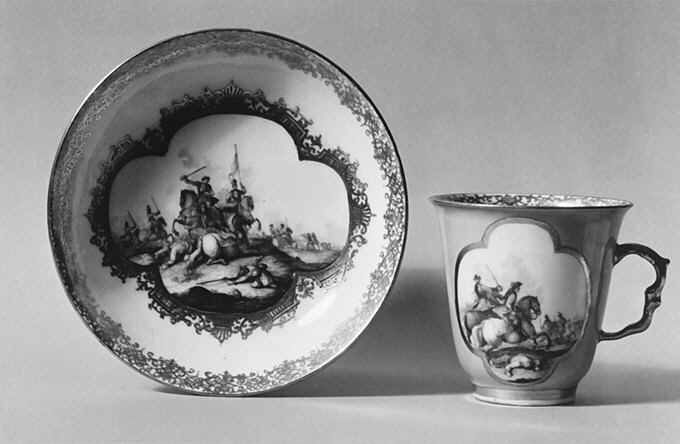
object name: cup and saucer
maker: meissen manufactory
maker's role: manufactory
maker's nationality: german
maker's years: 1710-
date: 1740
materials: hard paste porcelain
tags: human figures,horses